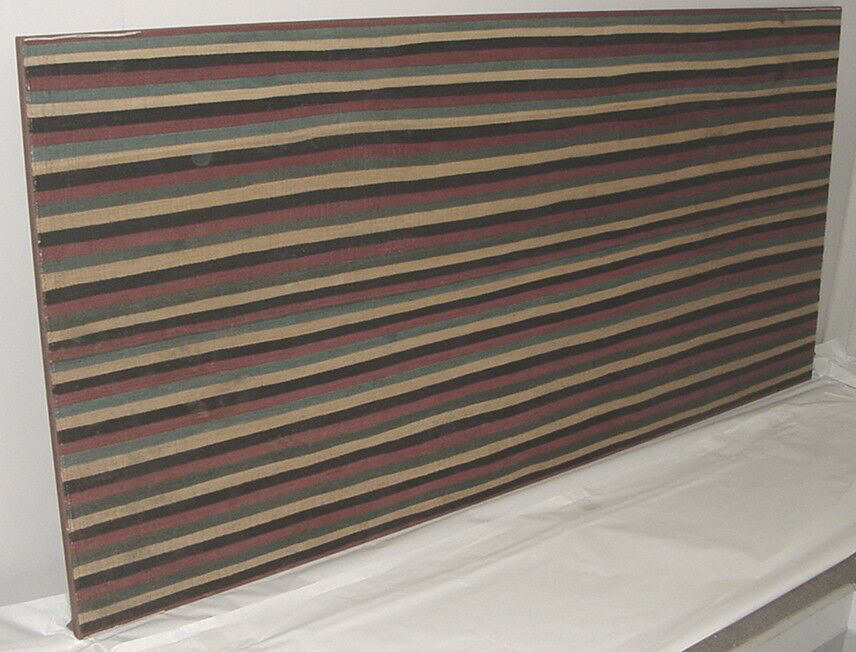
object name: tunic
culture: siguas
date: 1-700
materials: cotton, wool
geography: peru